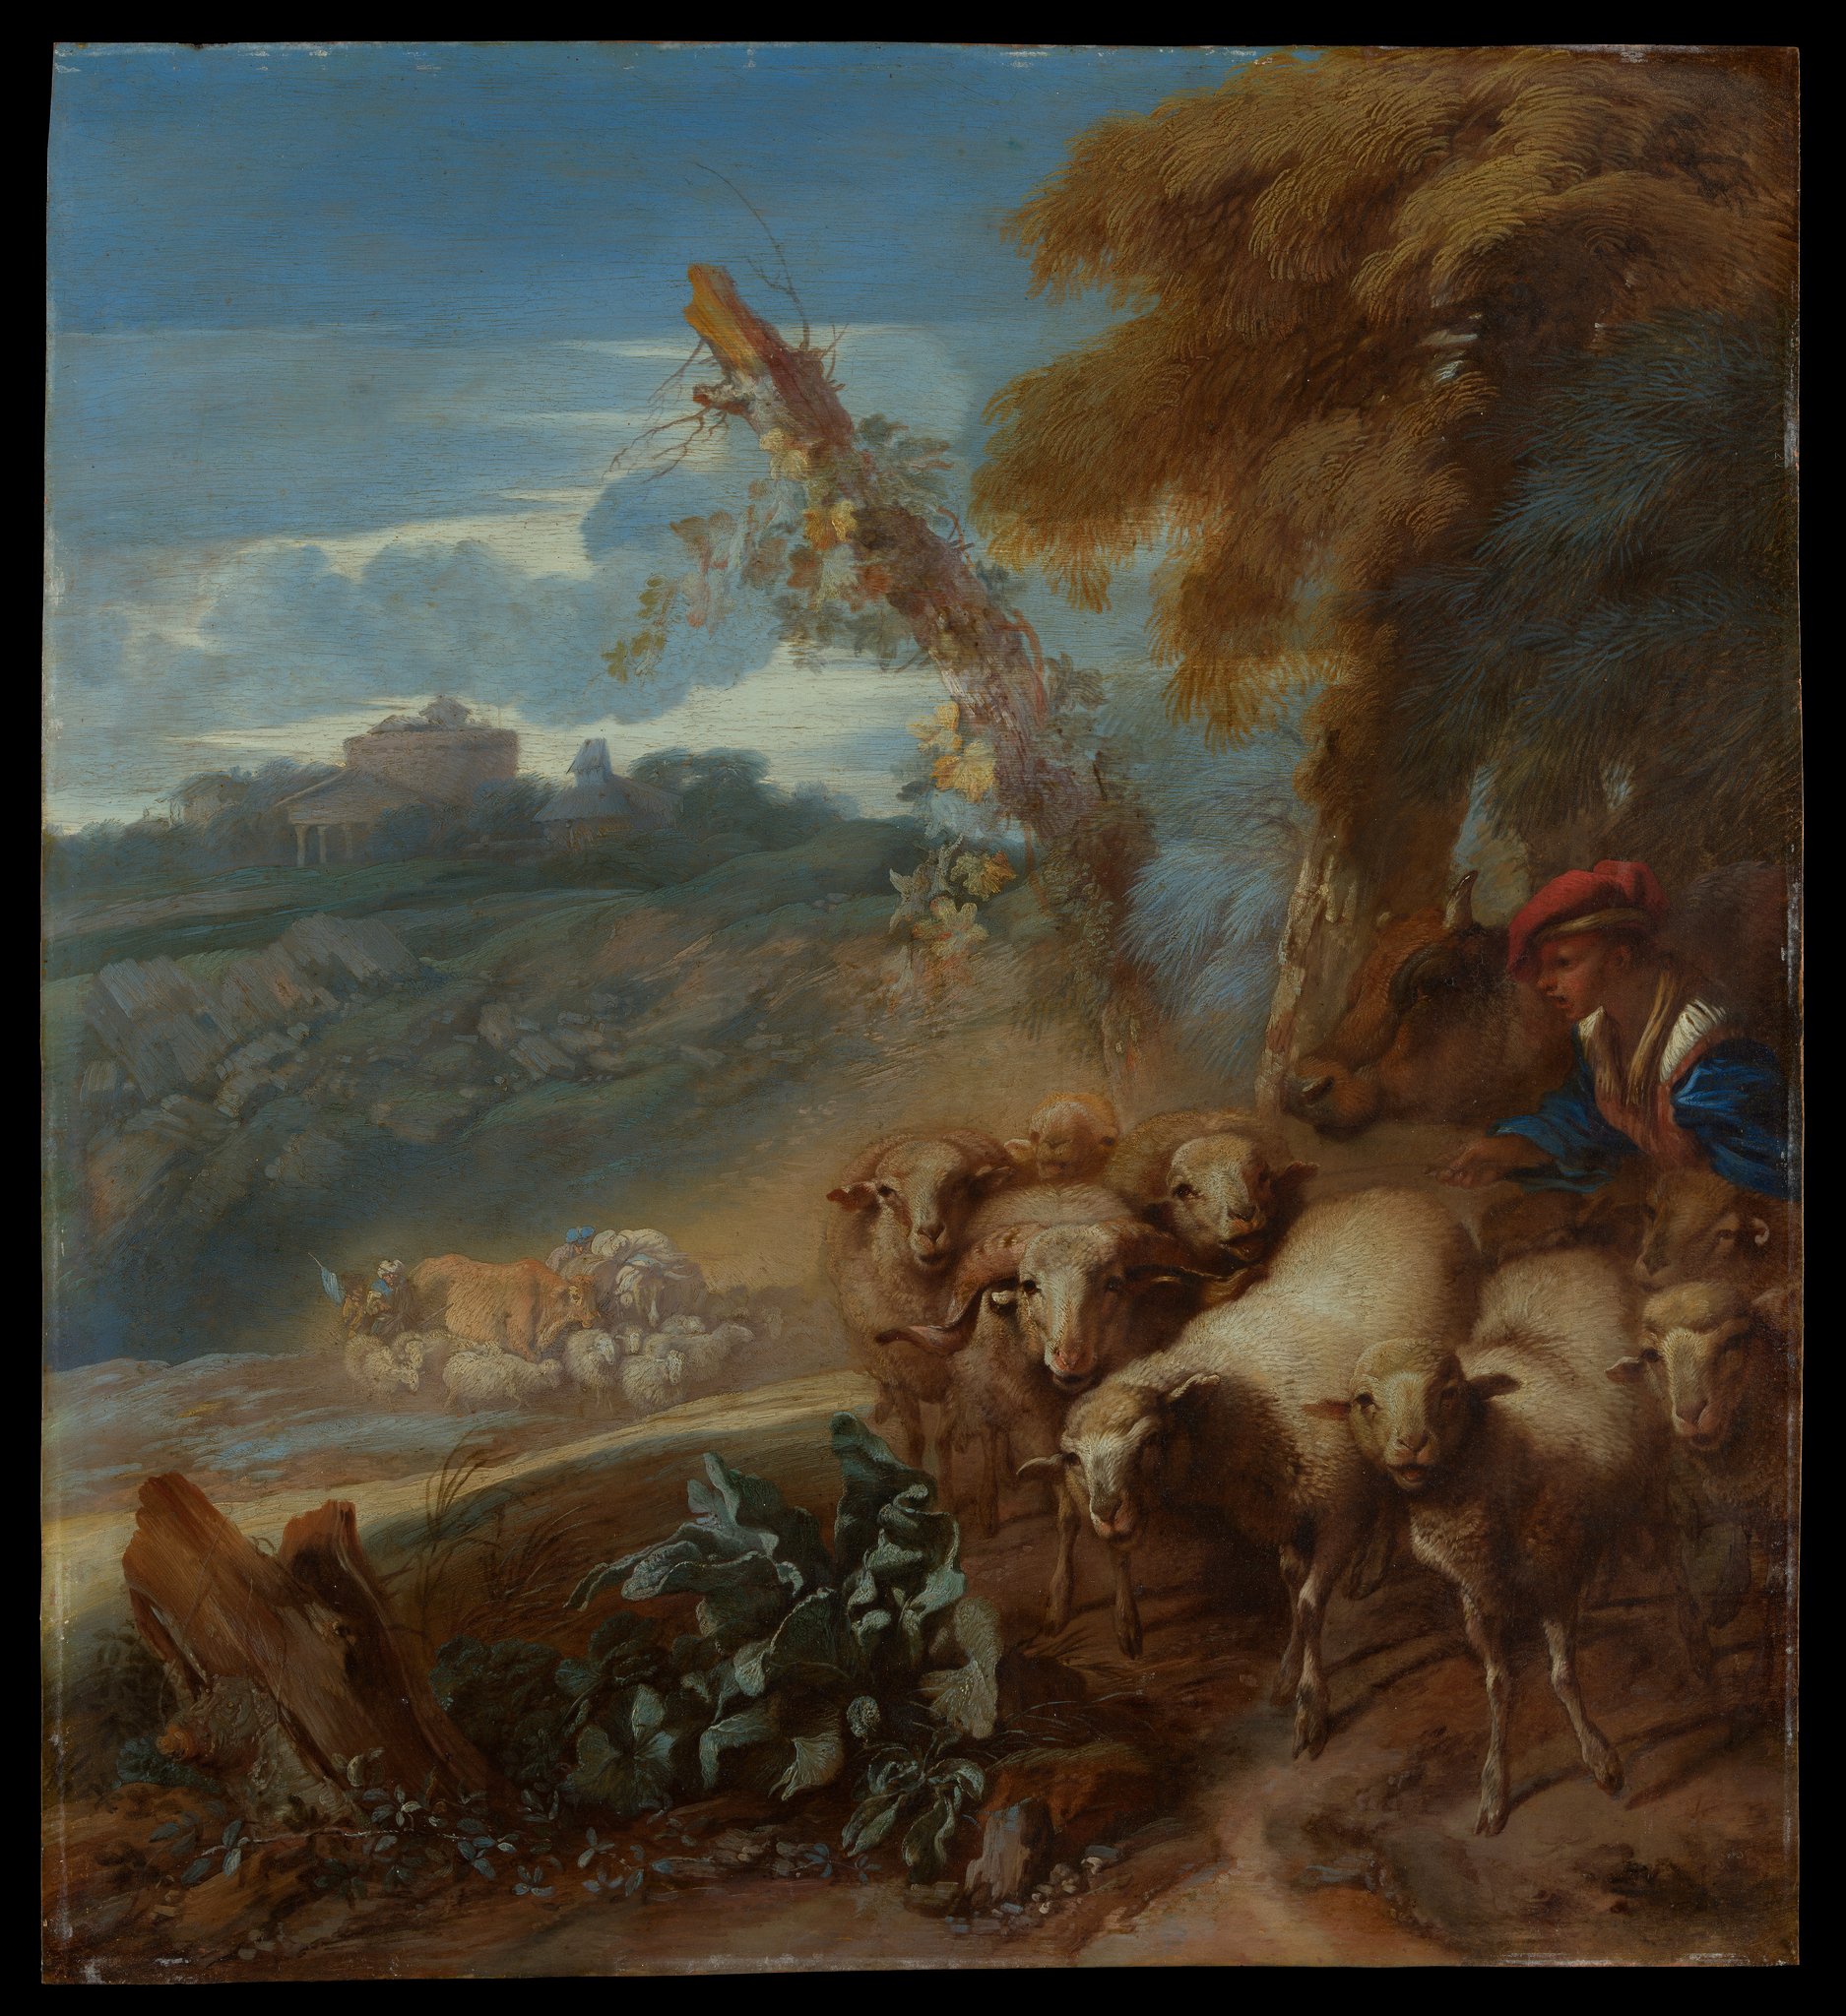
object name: painting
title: Roman Landscape with a Shepherd and Sheep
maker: giovanni benedetto castiglione (il grechetto)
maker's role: artist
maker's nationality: italian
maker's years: 1609-1664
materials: copper, oil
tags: sheep,shepherds,rome